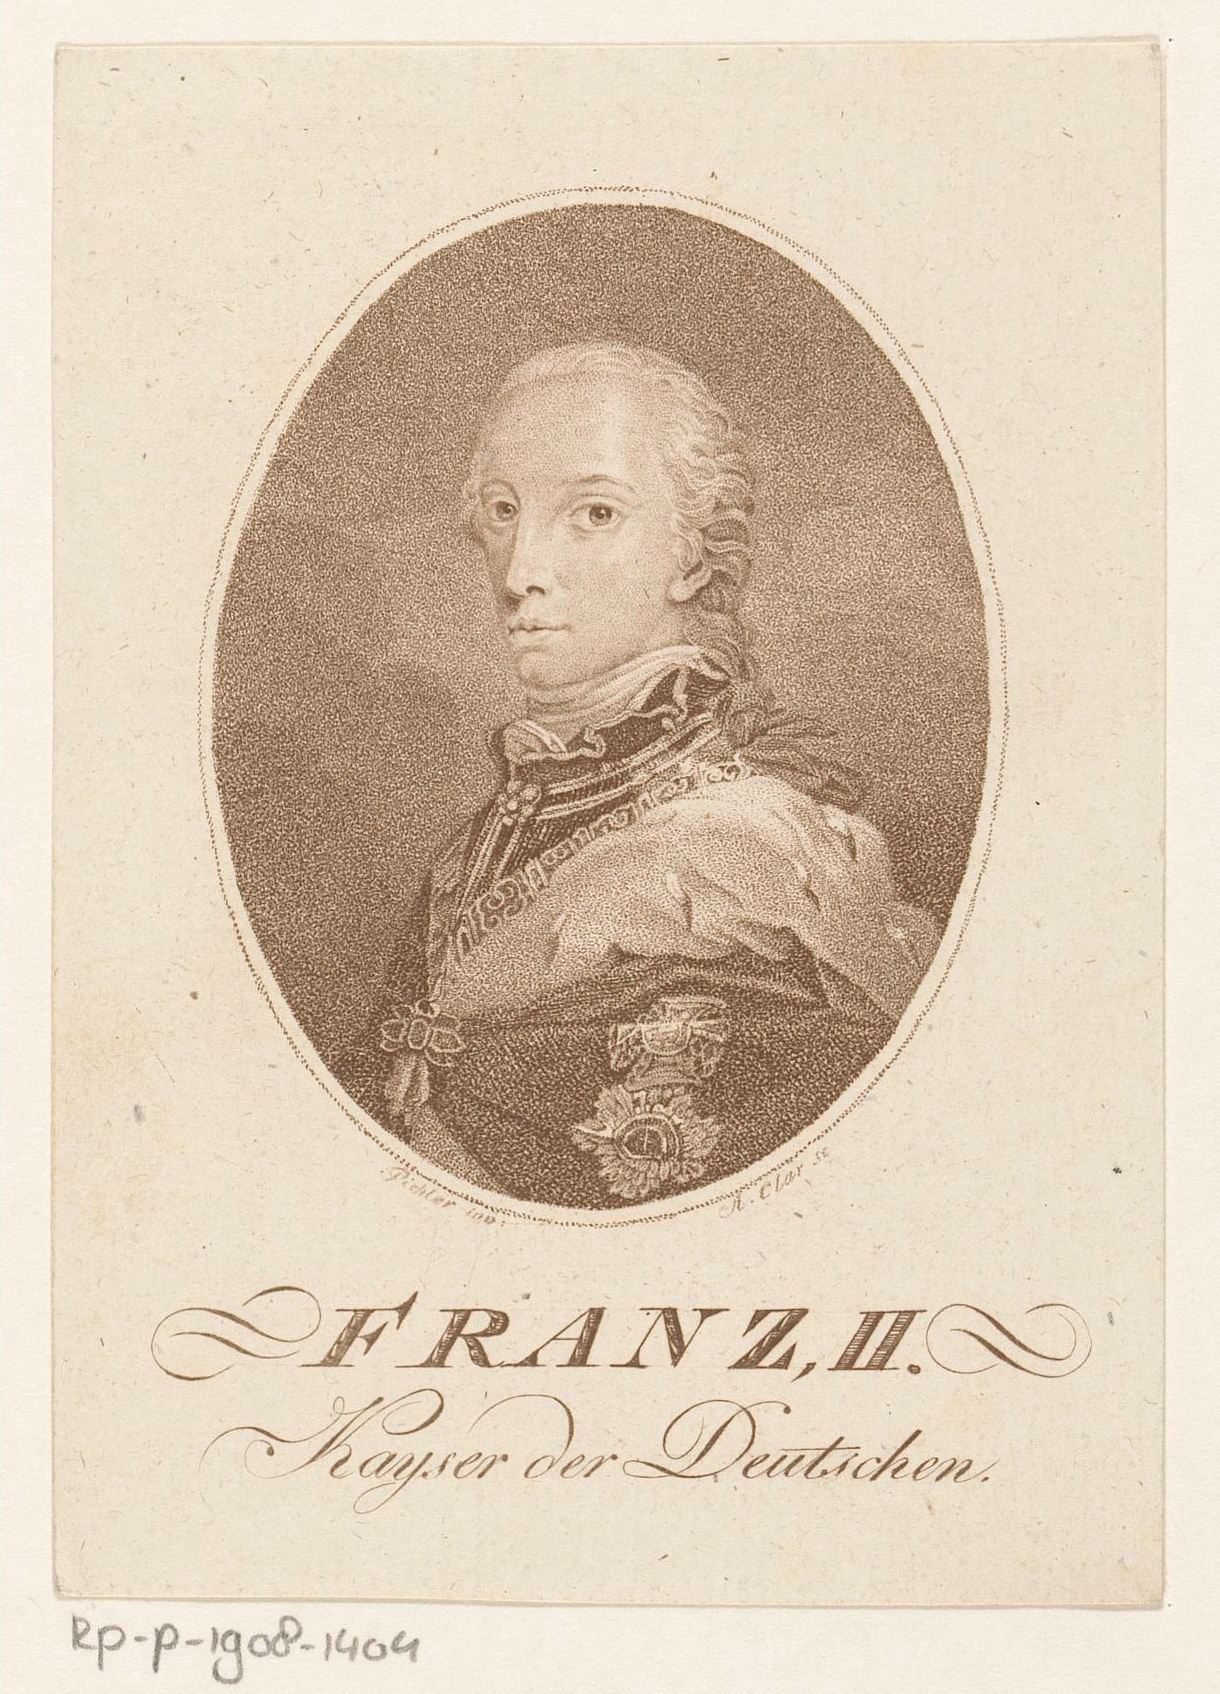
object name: print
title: Portret van Frans II Josef Karel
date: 1778-1844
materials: paper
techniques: stippling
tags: frans ii (rooms-duits keizer), knighthood order, historical persons, medals and other marks of military honour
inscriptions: collector's mark: Lugt 2228